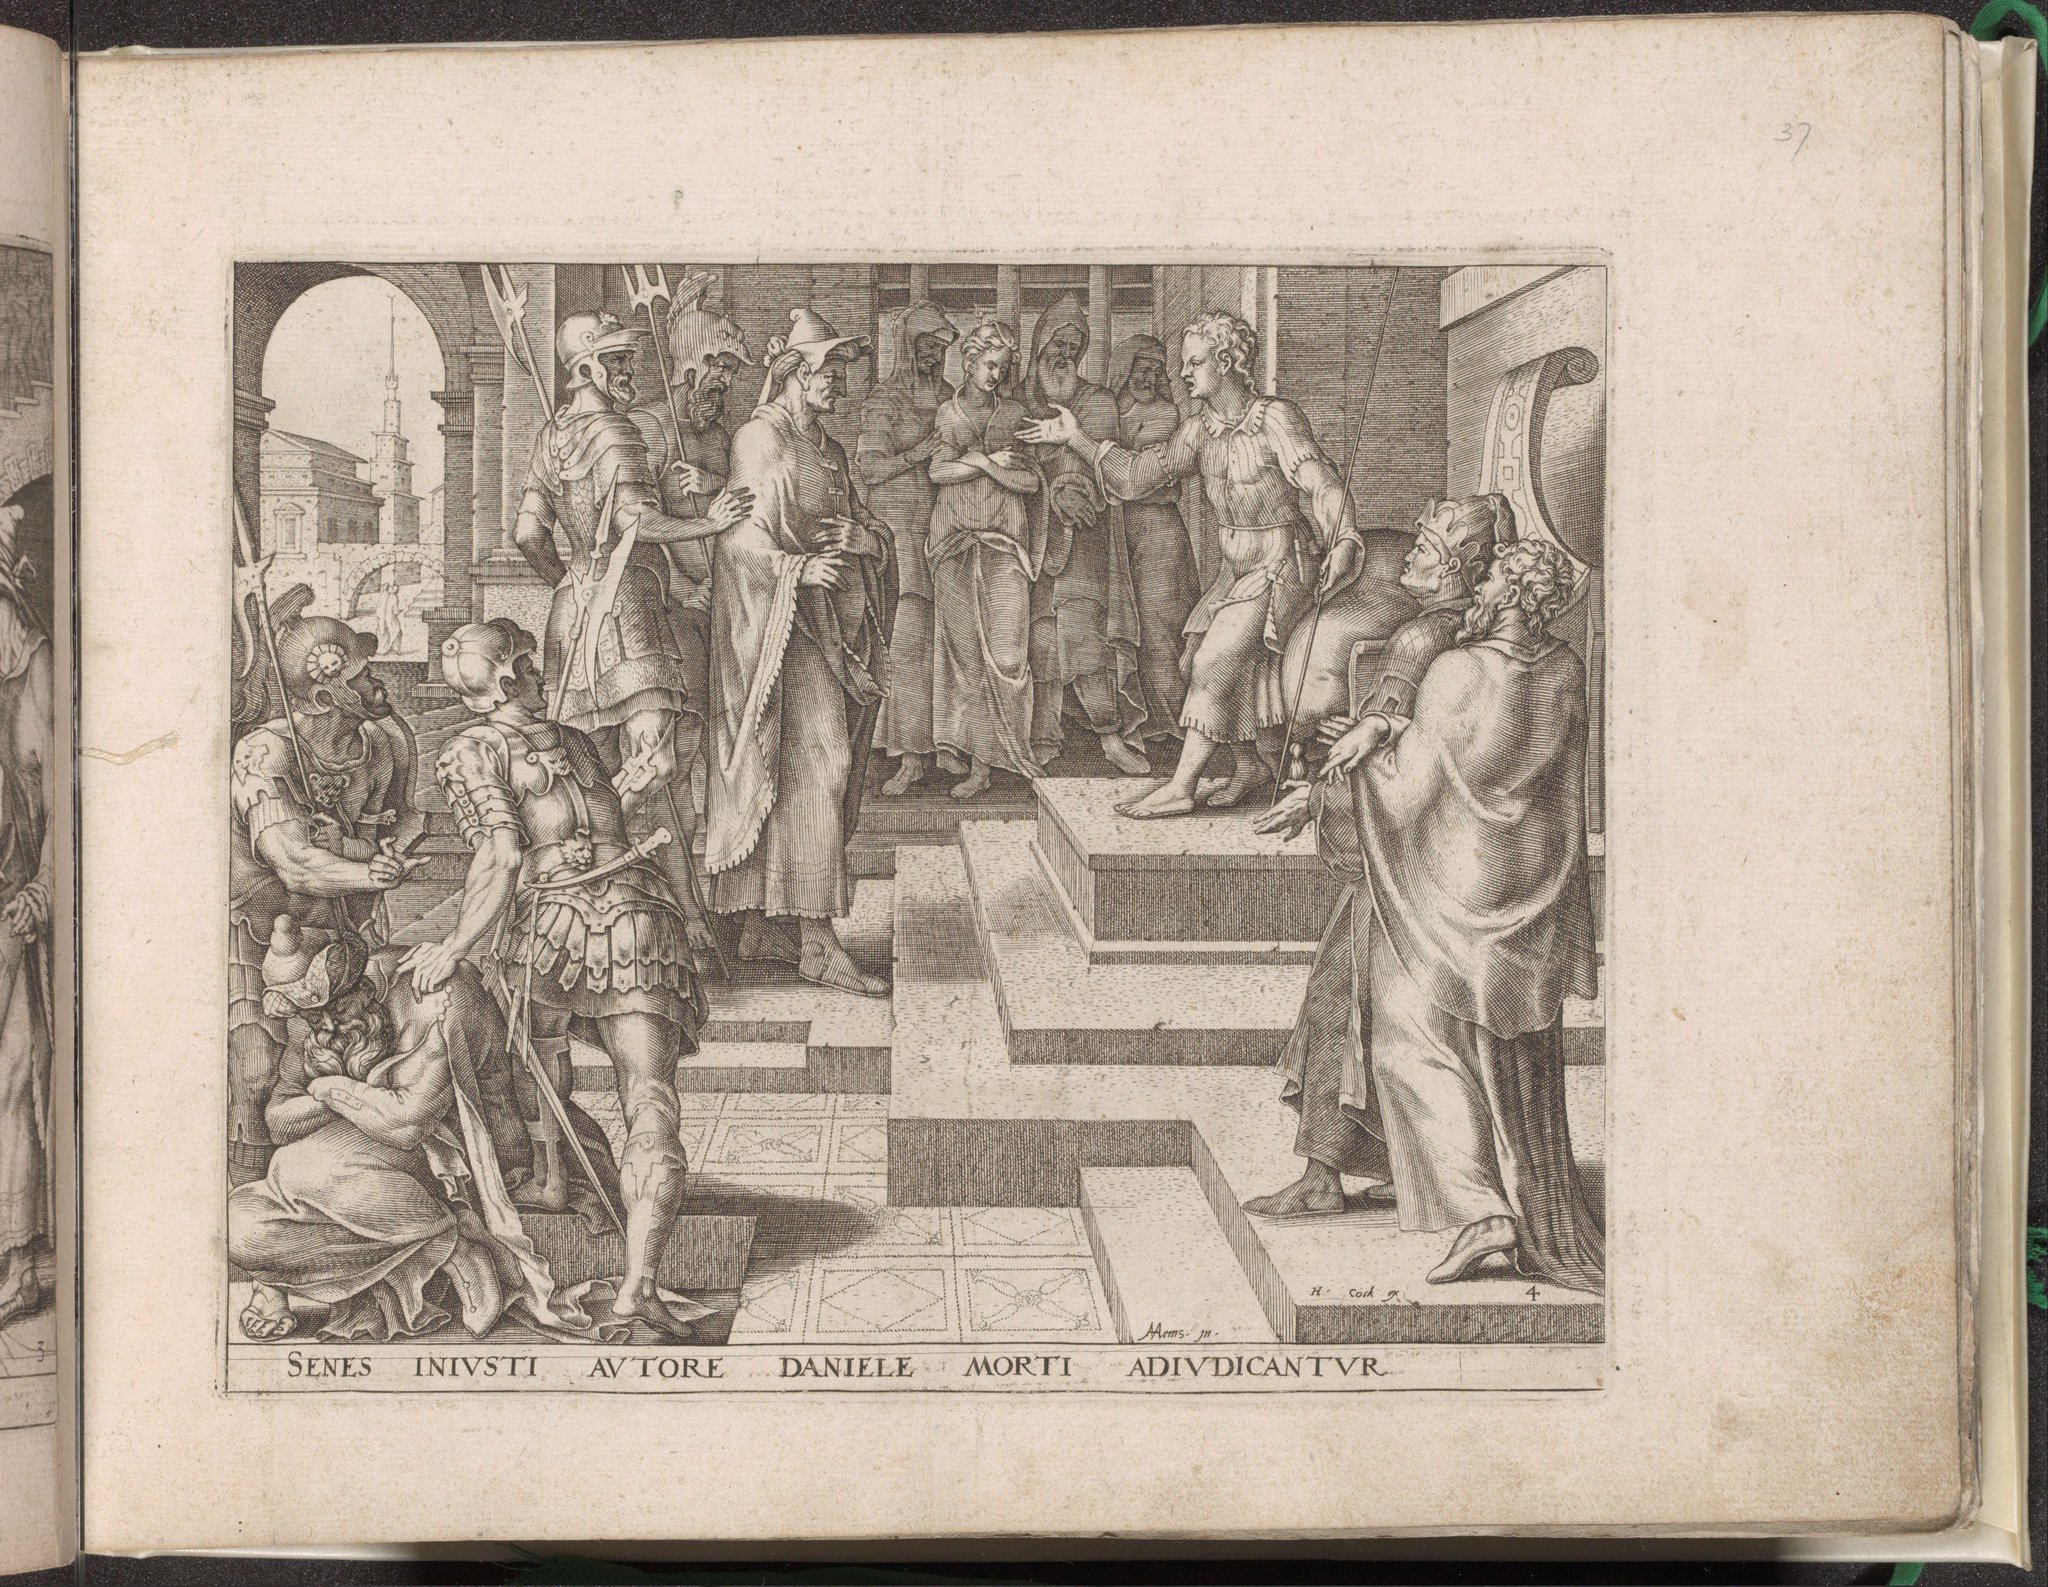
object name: album leaf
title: Geschiedenis van Susanna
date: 1563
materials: paper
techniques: engraving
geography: antwerp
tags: daniel interrogates the elders separately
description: Daniël ondervraagt de oudsten apart van elkaar om het valse getuigenis van de twee aan het licht te brengen. Daniël staat voor de rechterstoel en spreekt tot een van de ouderlingen. De tweede ouderling zit linksonder in de hoek. Op de achtergrond Susanna. Onder de voorstelling een verklarende tekst in het Latijn. Deze prent maakt deel uit van een album.